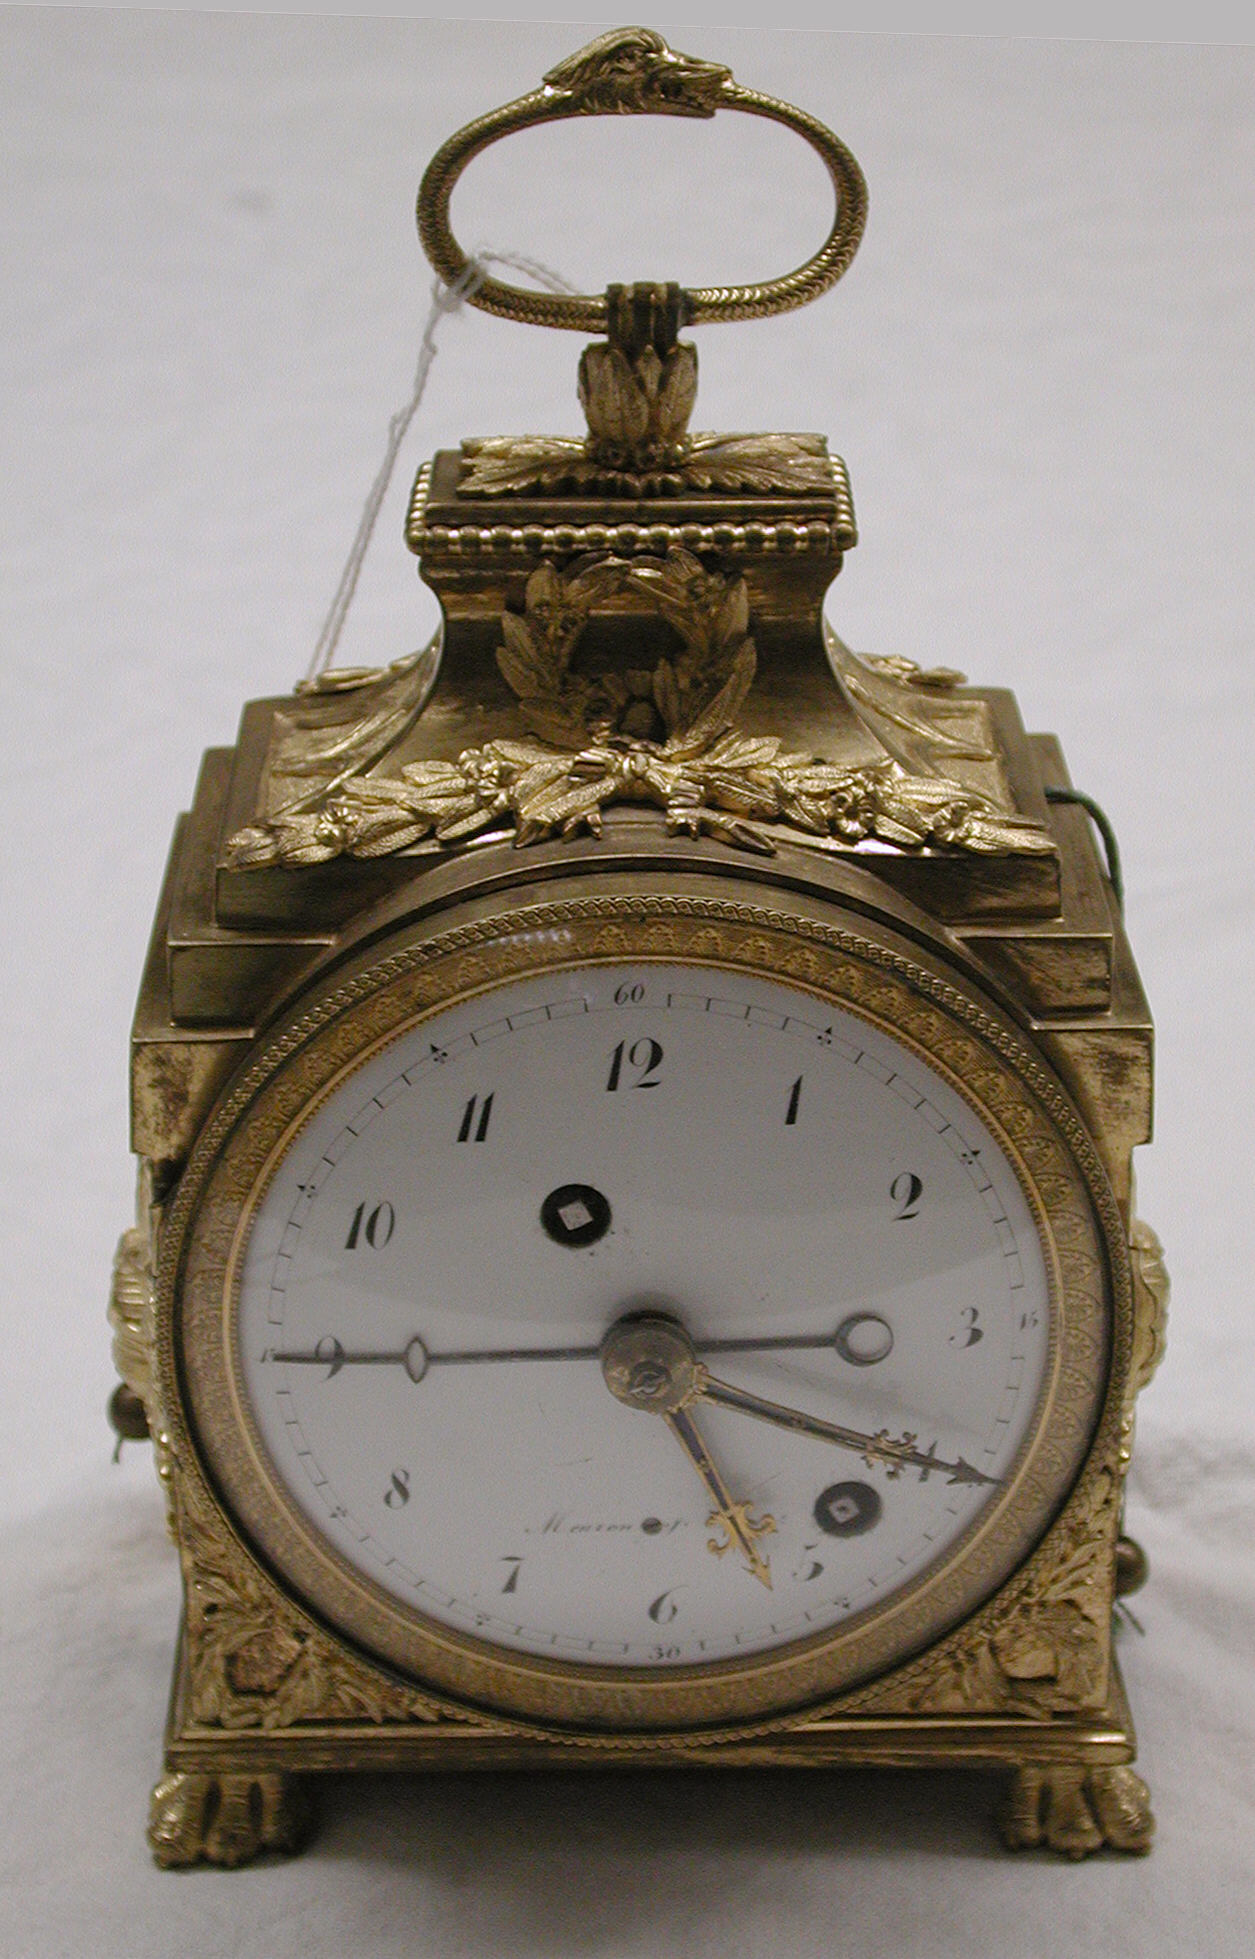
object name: clock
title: Clock (pendule d'officier)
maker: firm of meuron et companie, geneva and paris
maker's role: maker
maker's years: 1785-1810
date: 1800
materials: brass, enamel, gilt bronze, steel